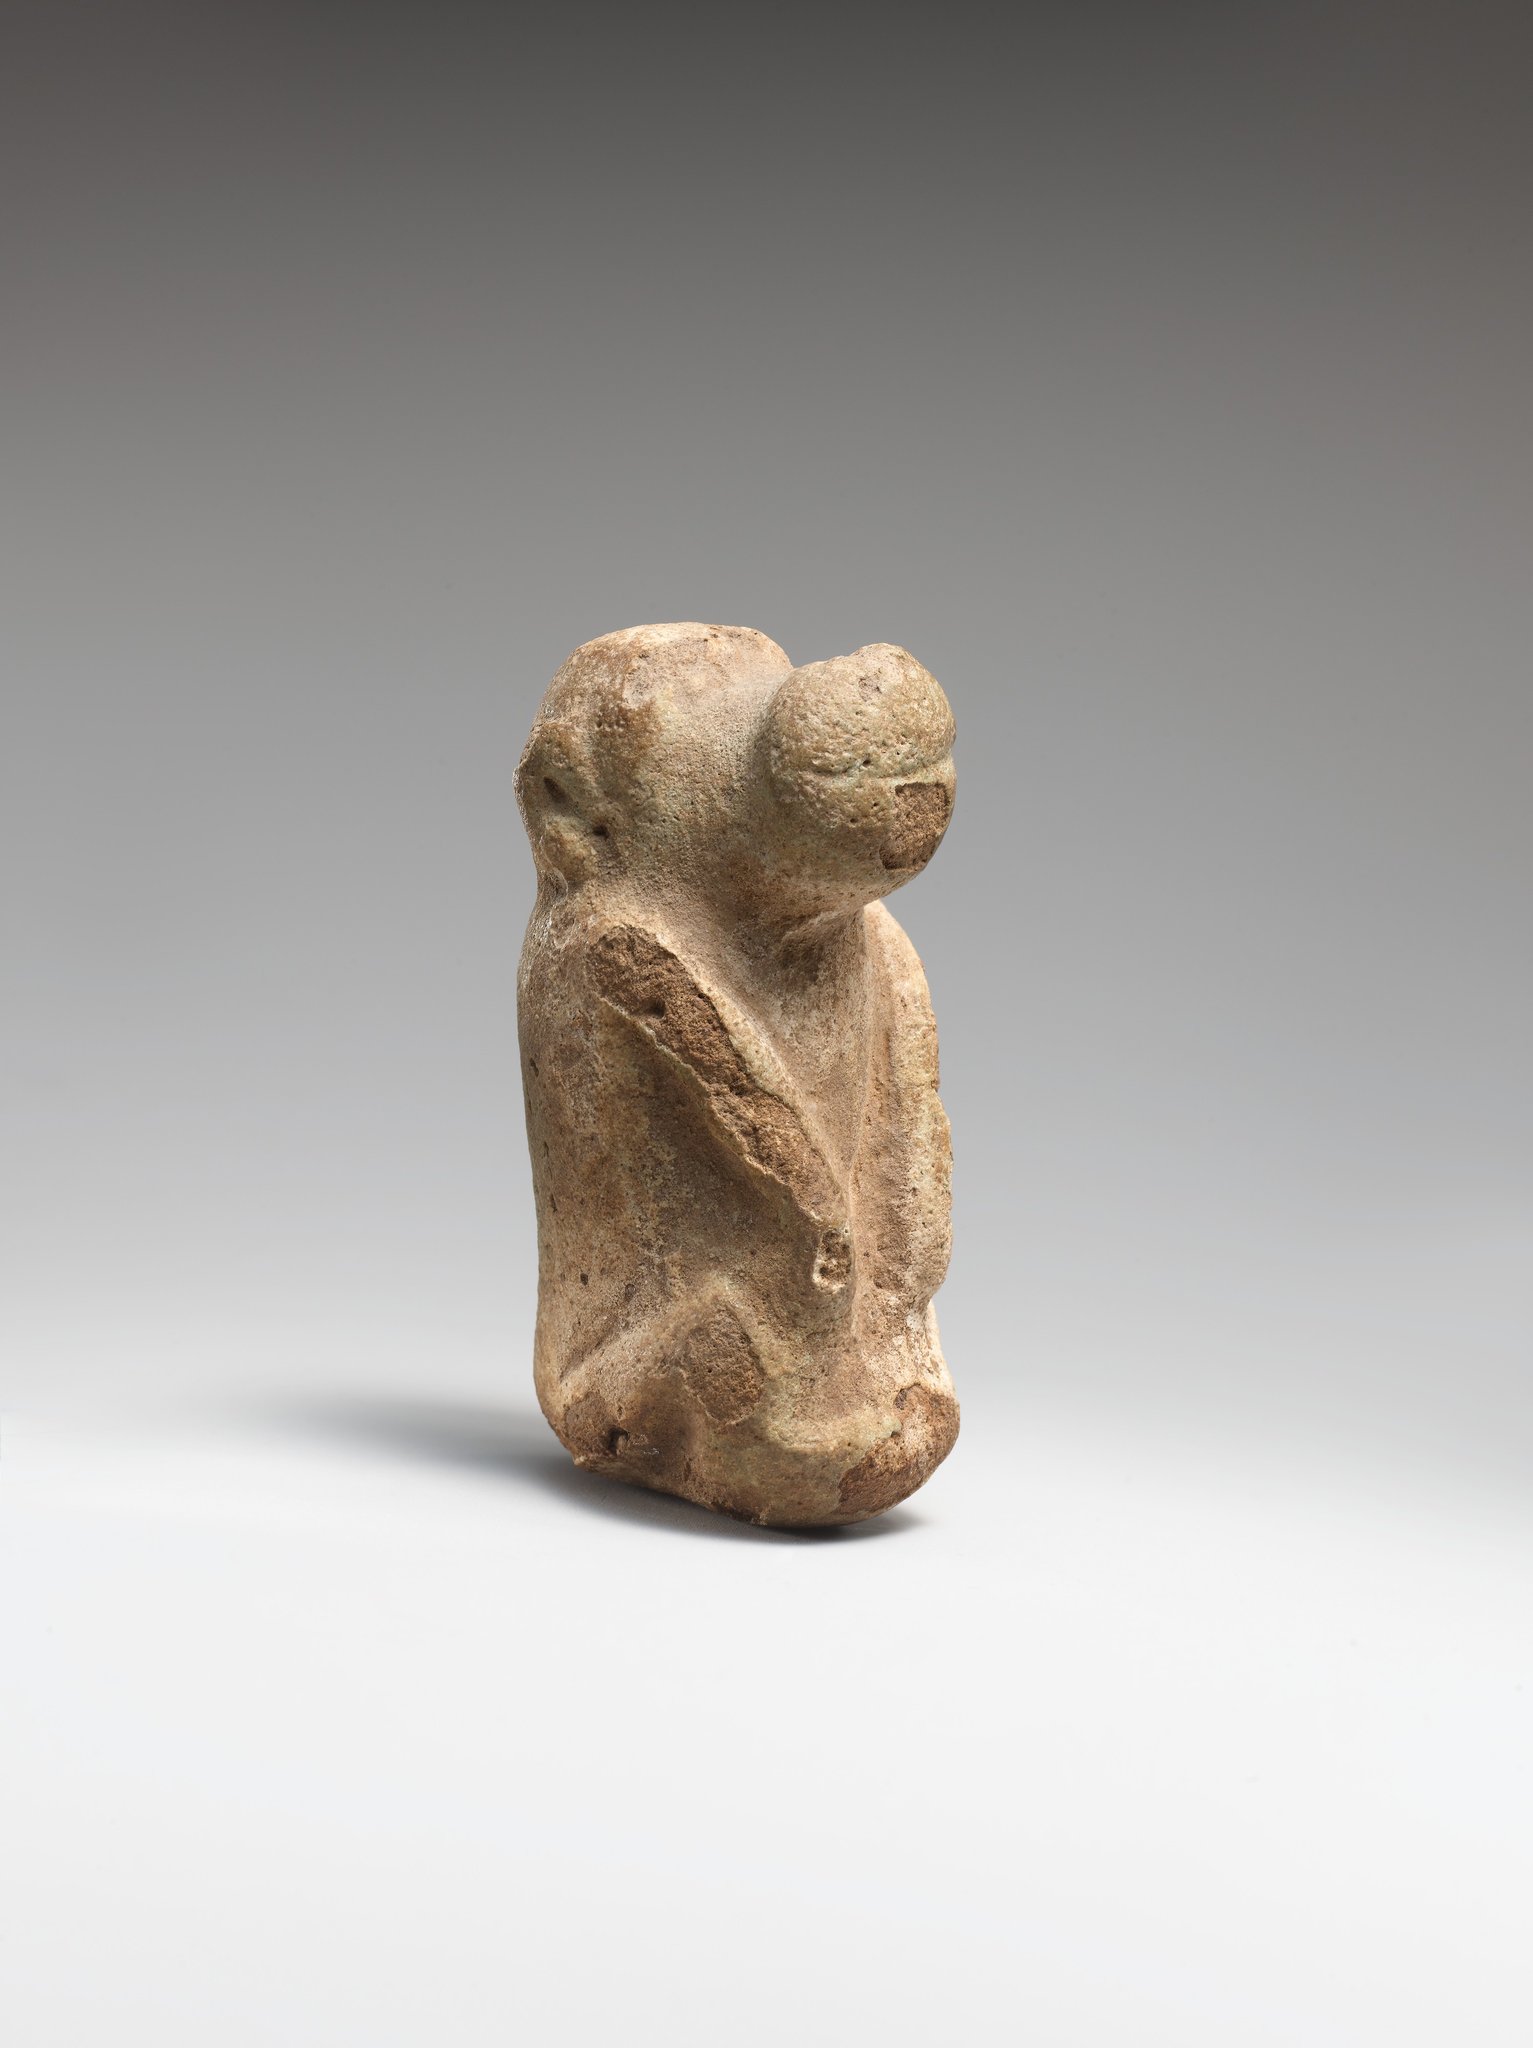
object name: figurine, baboon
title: Juvenile Baboon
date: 3100-2649 BCE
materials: faience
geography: egypt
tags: baboons